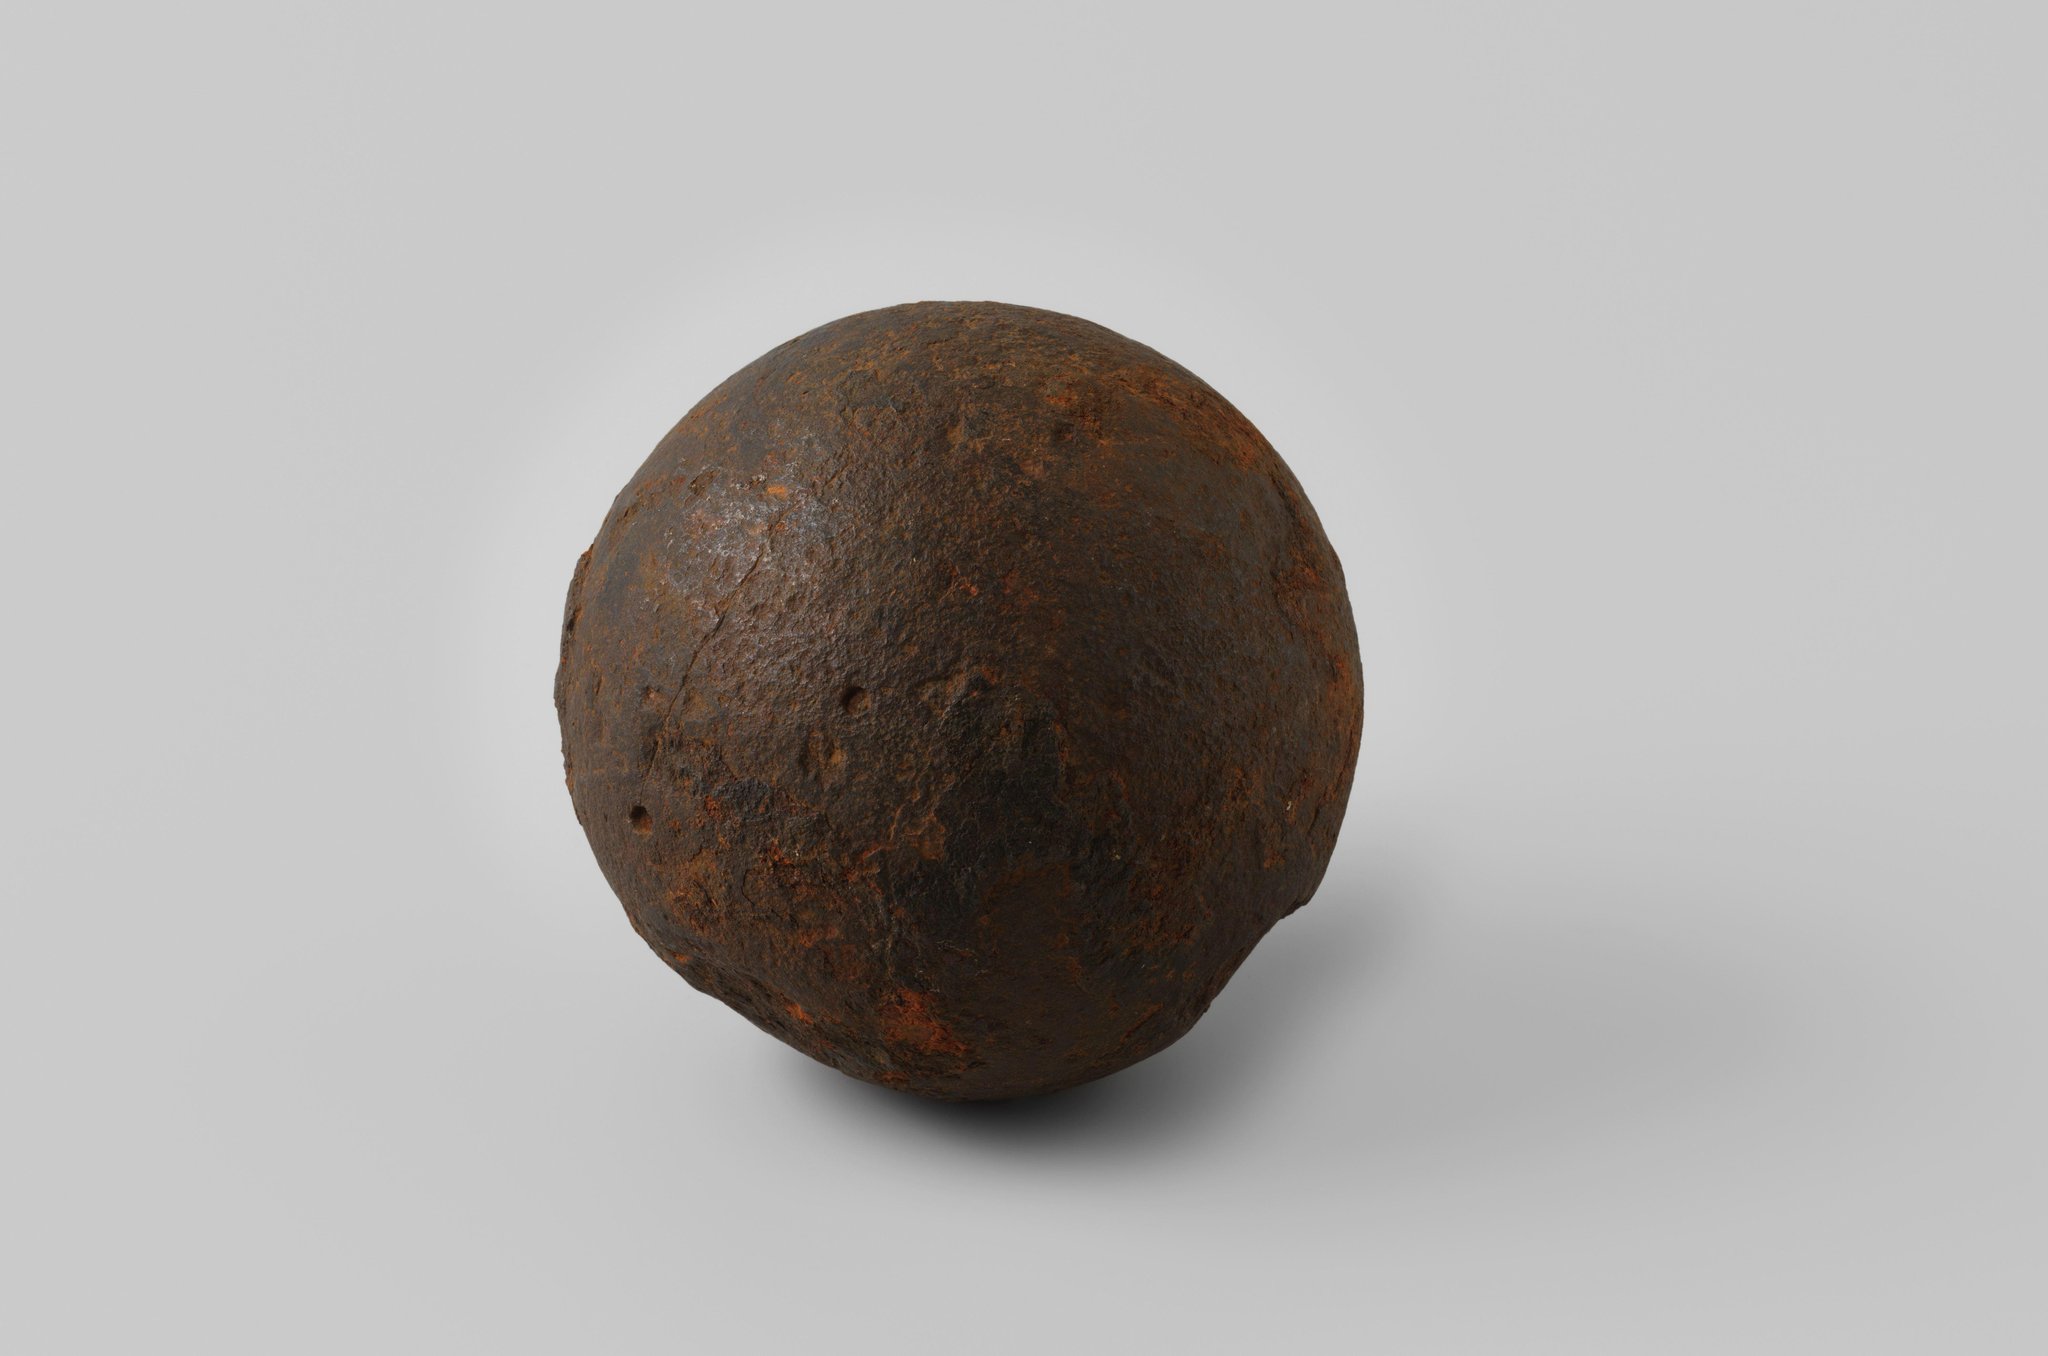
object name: bullet ammunition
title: Cannonball from the wreck of the Dutch East Indiaman 't Vliegend Hart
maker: Anonymous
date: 1700-1743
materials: iron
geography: netherlands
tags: verenigde oostindische compagnie, hollandia (schip), annet